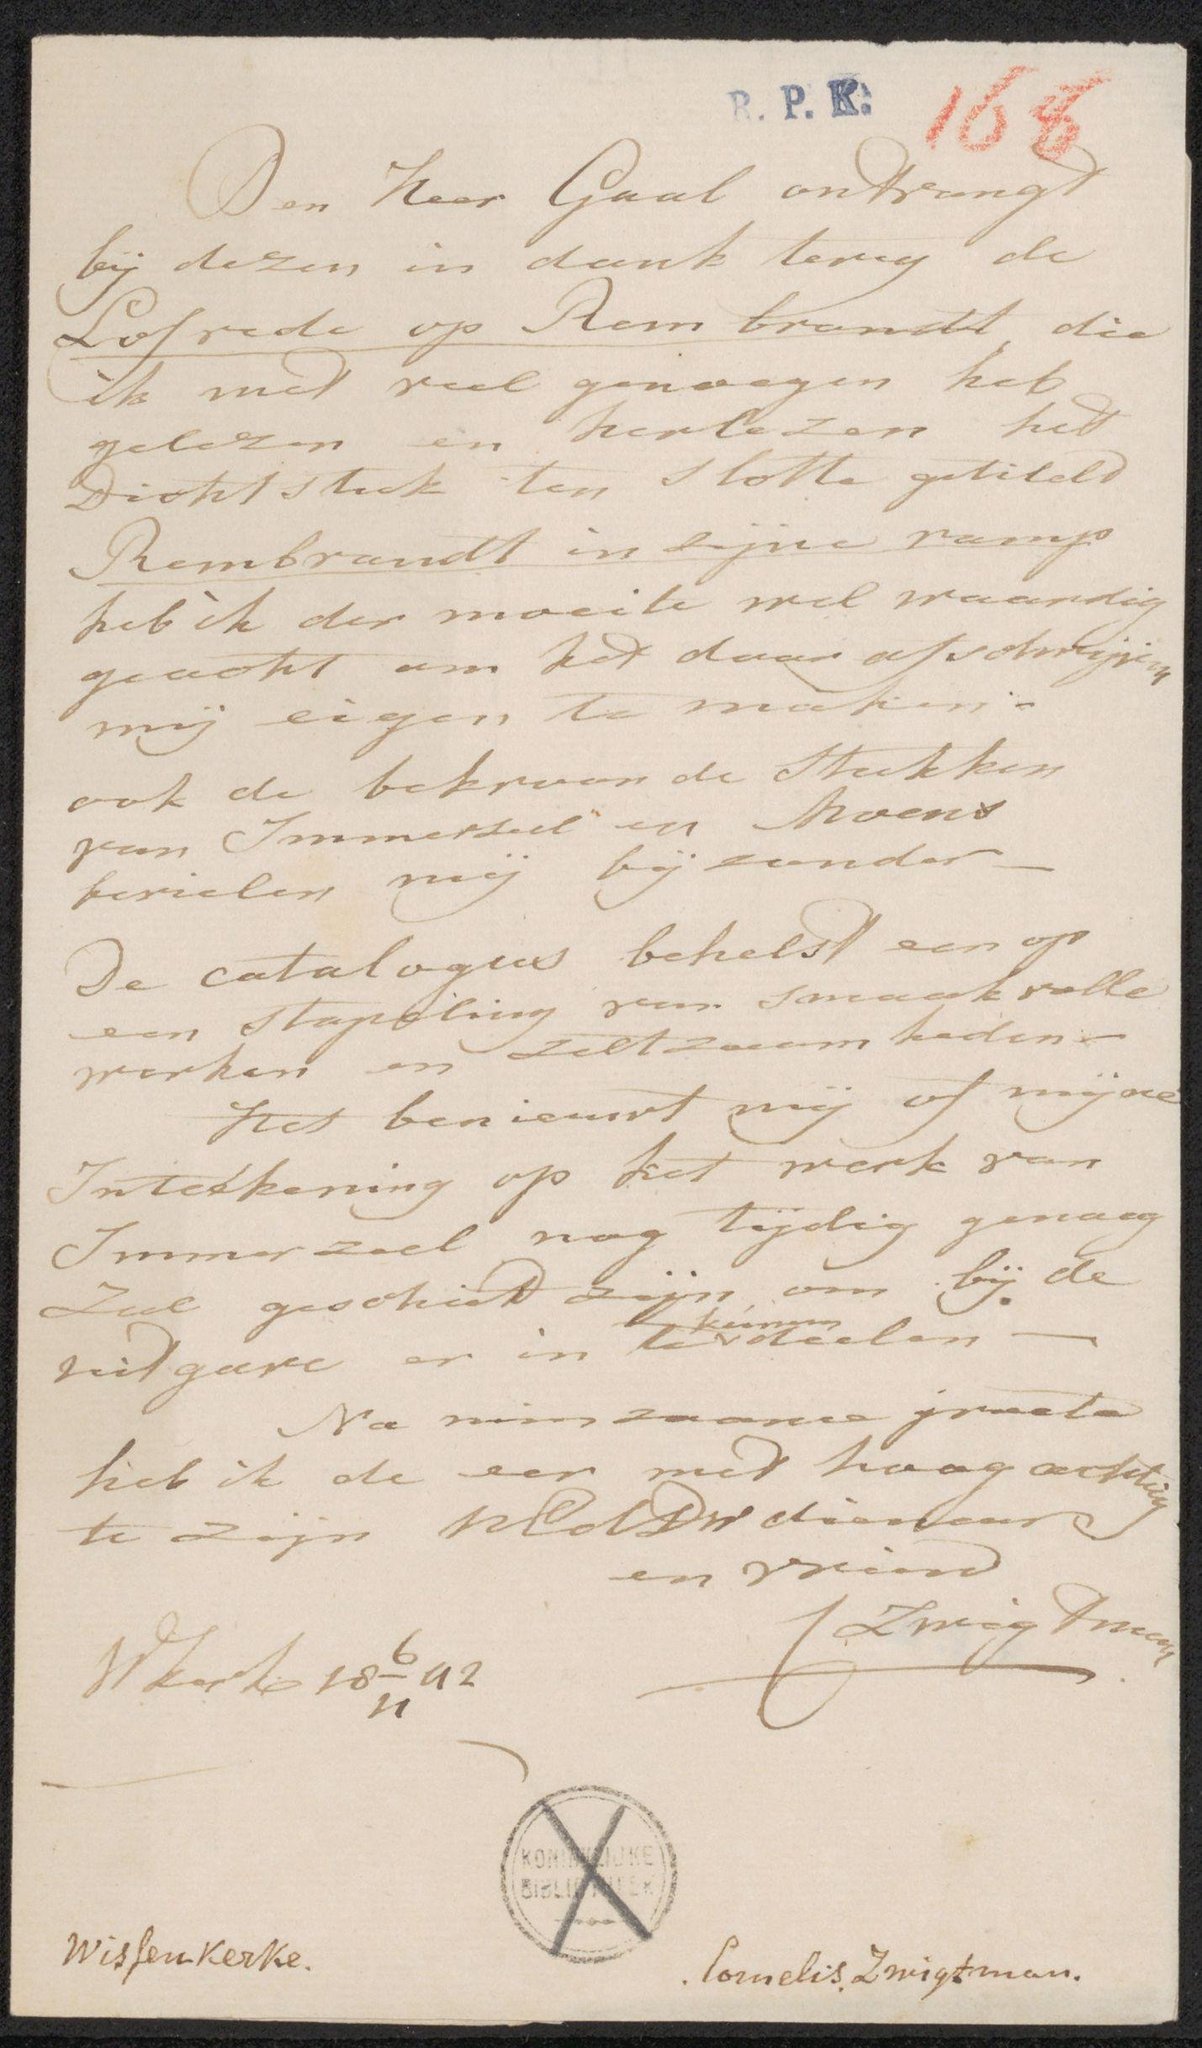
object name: letter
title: Brief aan Jacob Cornelis Gaal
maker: cornelis zwigtman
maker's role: draughtsman, painter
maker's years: 1782-1866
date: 1842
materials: ink, paper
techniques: pen, writing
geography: westkapelle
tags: publisher, johannes immerzeel, jacobus cornelis gaal, leiden, amsterdam, painter, print maker, draughtsman, rembrandt van rijn, printed matter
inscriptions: collector's mark: Lugt 2233, collector's mark: ‘KONINKLIJKE BIBLIOTHEEK’, watermark